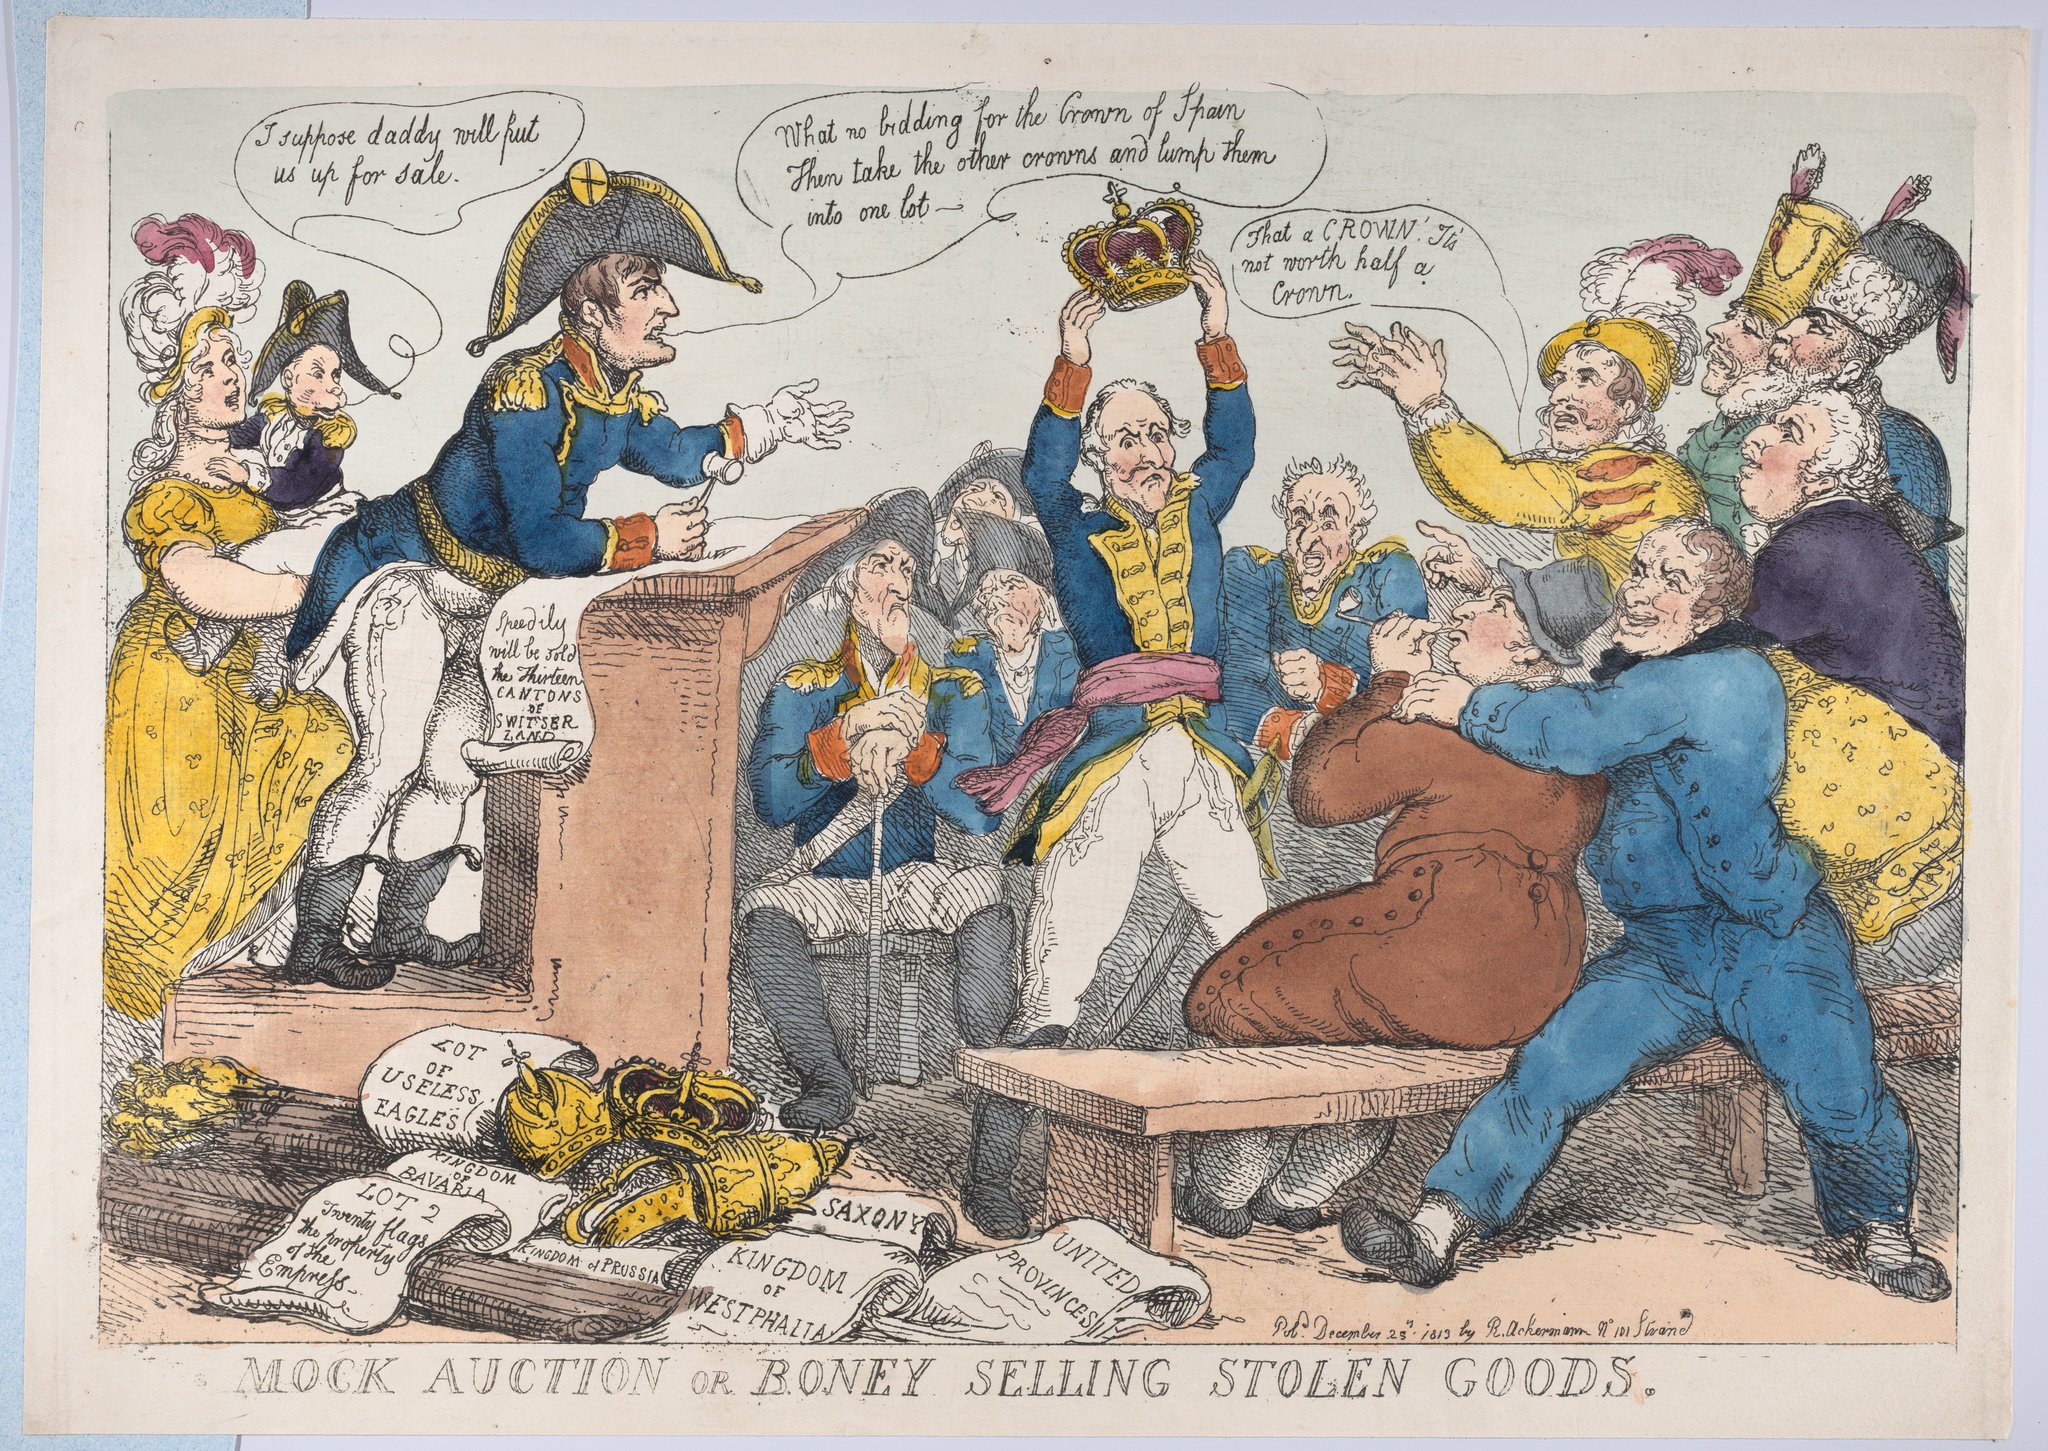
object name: print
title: Mock Auction or Boney Selling Stolen Goods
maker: thomas rowlandson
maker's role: artist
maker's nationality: british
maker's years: 1757-1827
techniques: etching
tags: satire,napoleon i,men,women,politics